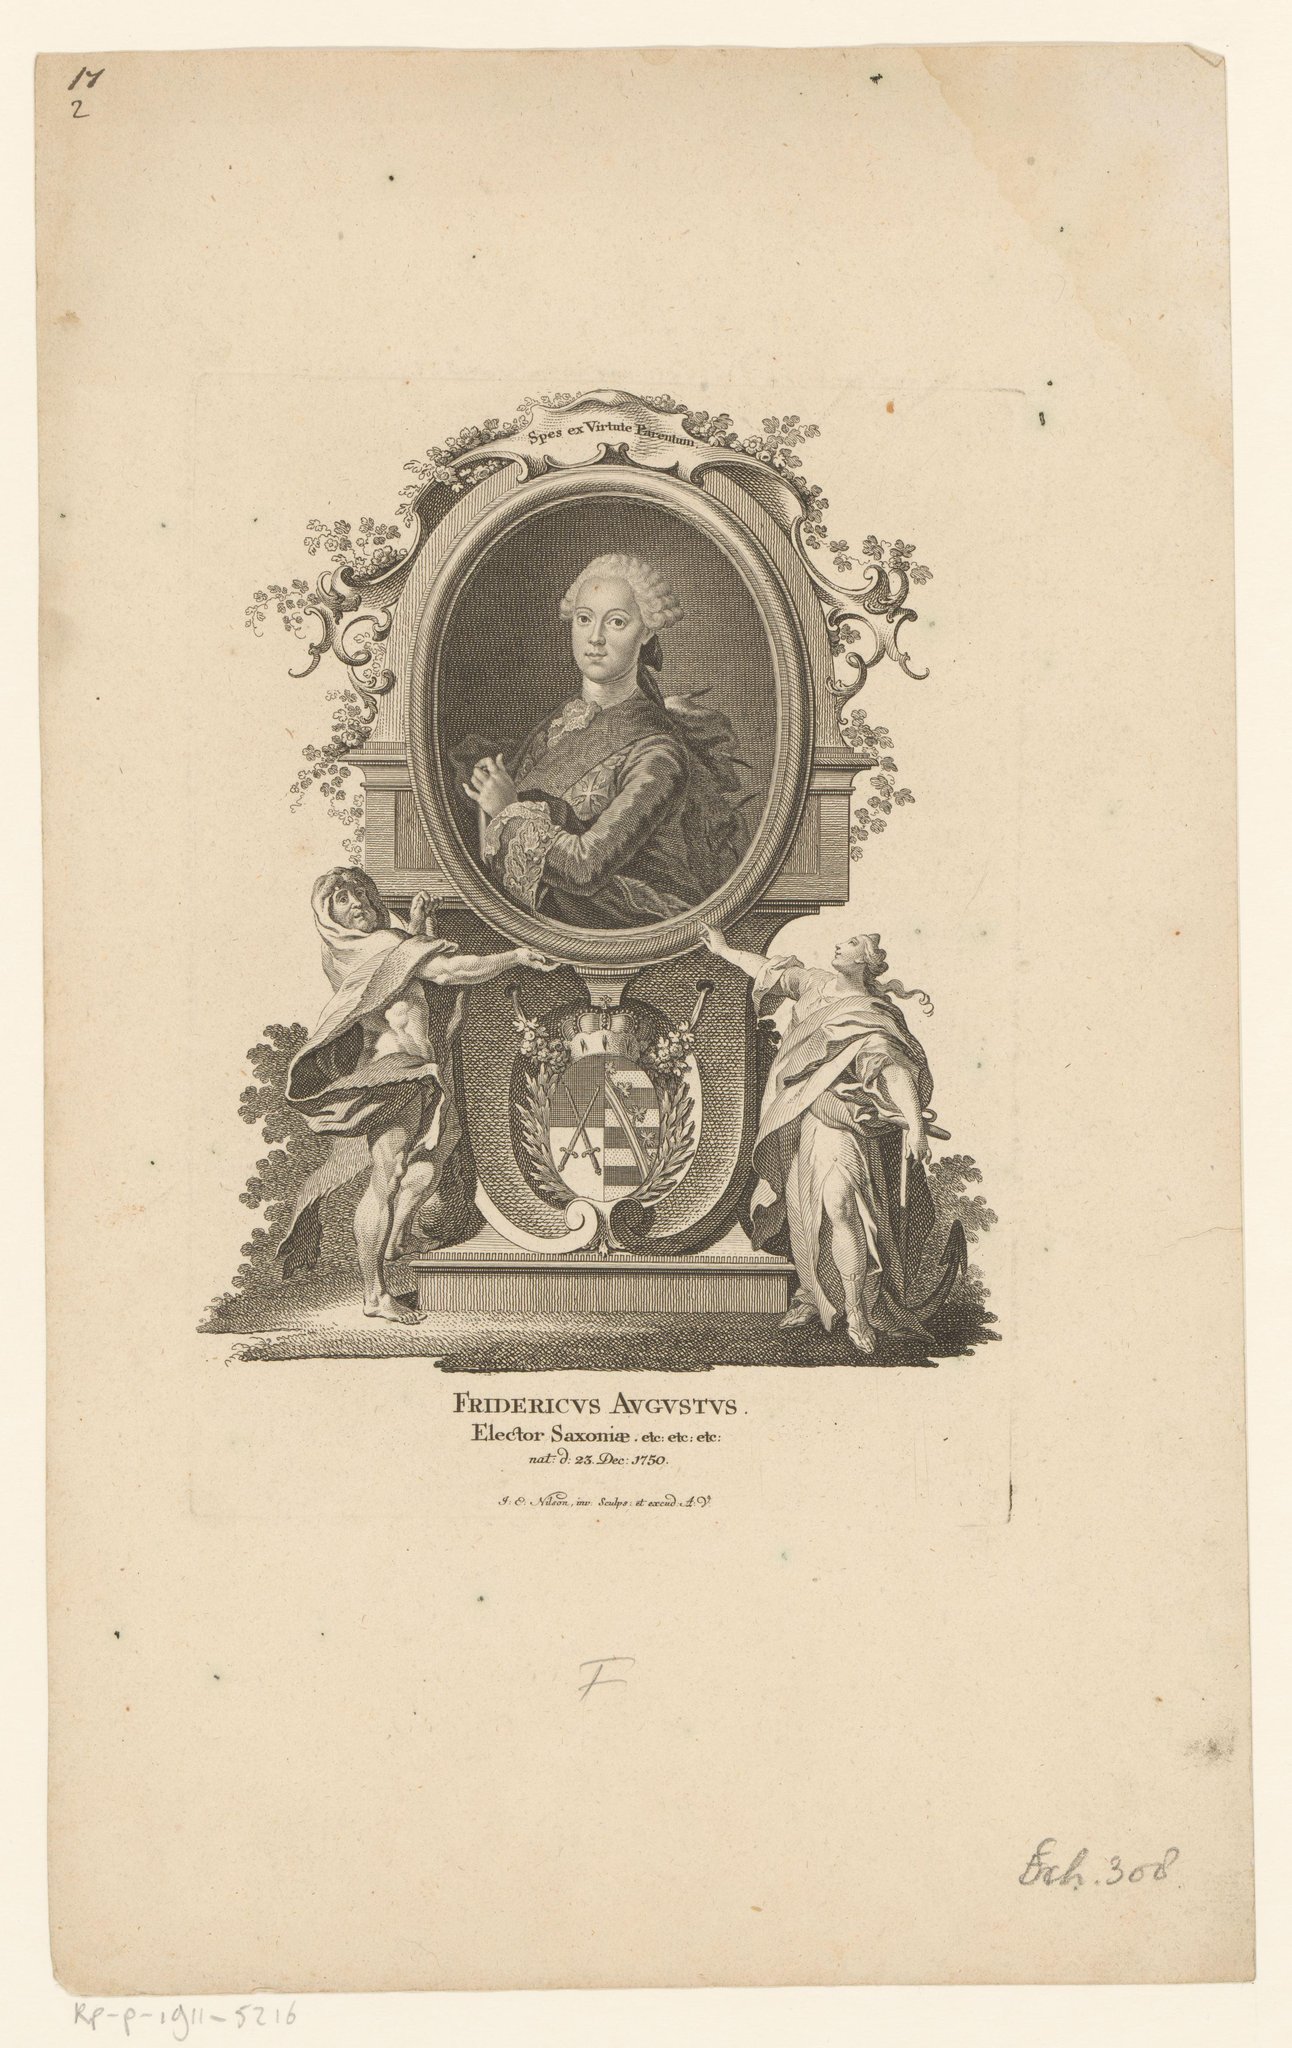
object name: print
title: Portret van Friedrich August I von Sachsen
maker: johann esaias nilson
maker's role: draughtsman, print maker, publisher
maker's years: 1721-1788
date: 1760-1788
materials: paper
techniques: engraving, etching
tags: frederik august i (koning van saksen), attributes of hercules (with name), historical persons, parts of ship's exterior: anchor, armorial bearing, heraldry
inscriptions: collector's mark: Lugt 2228